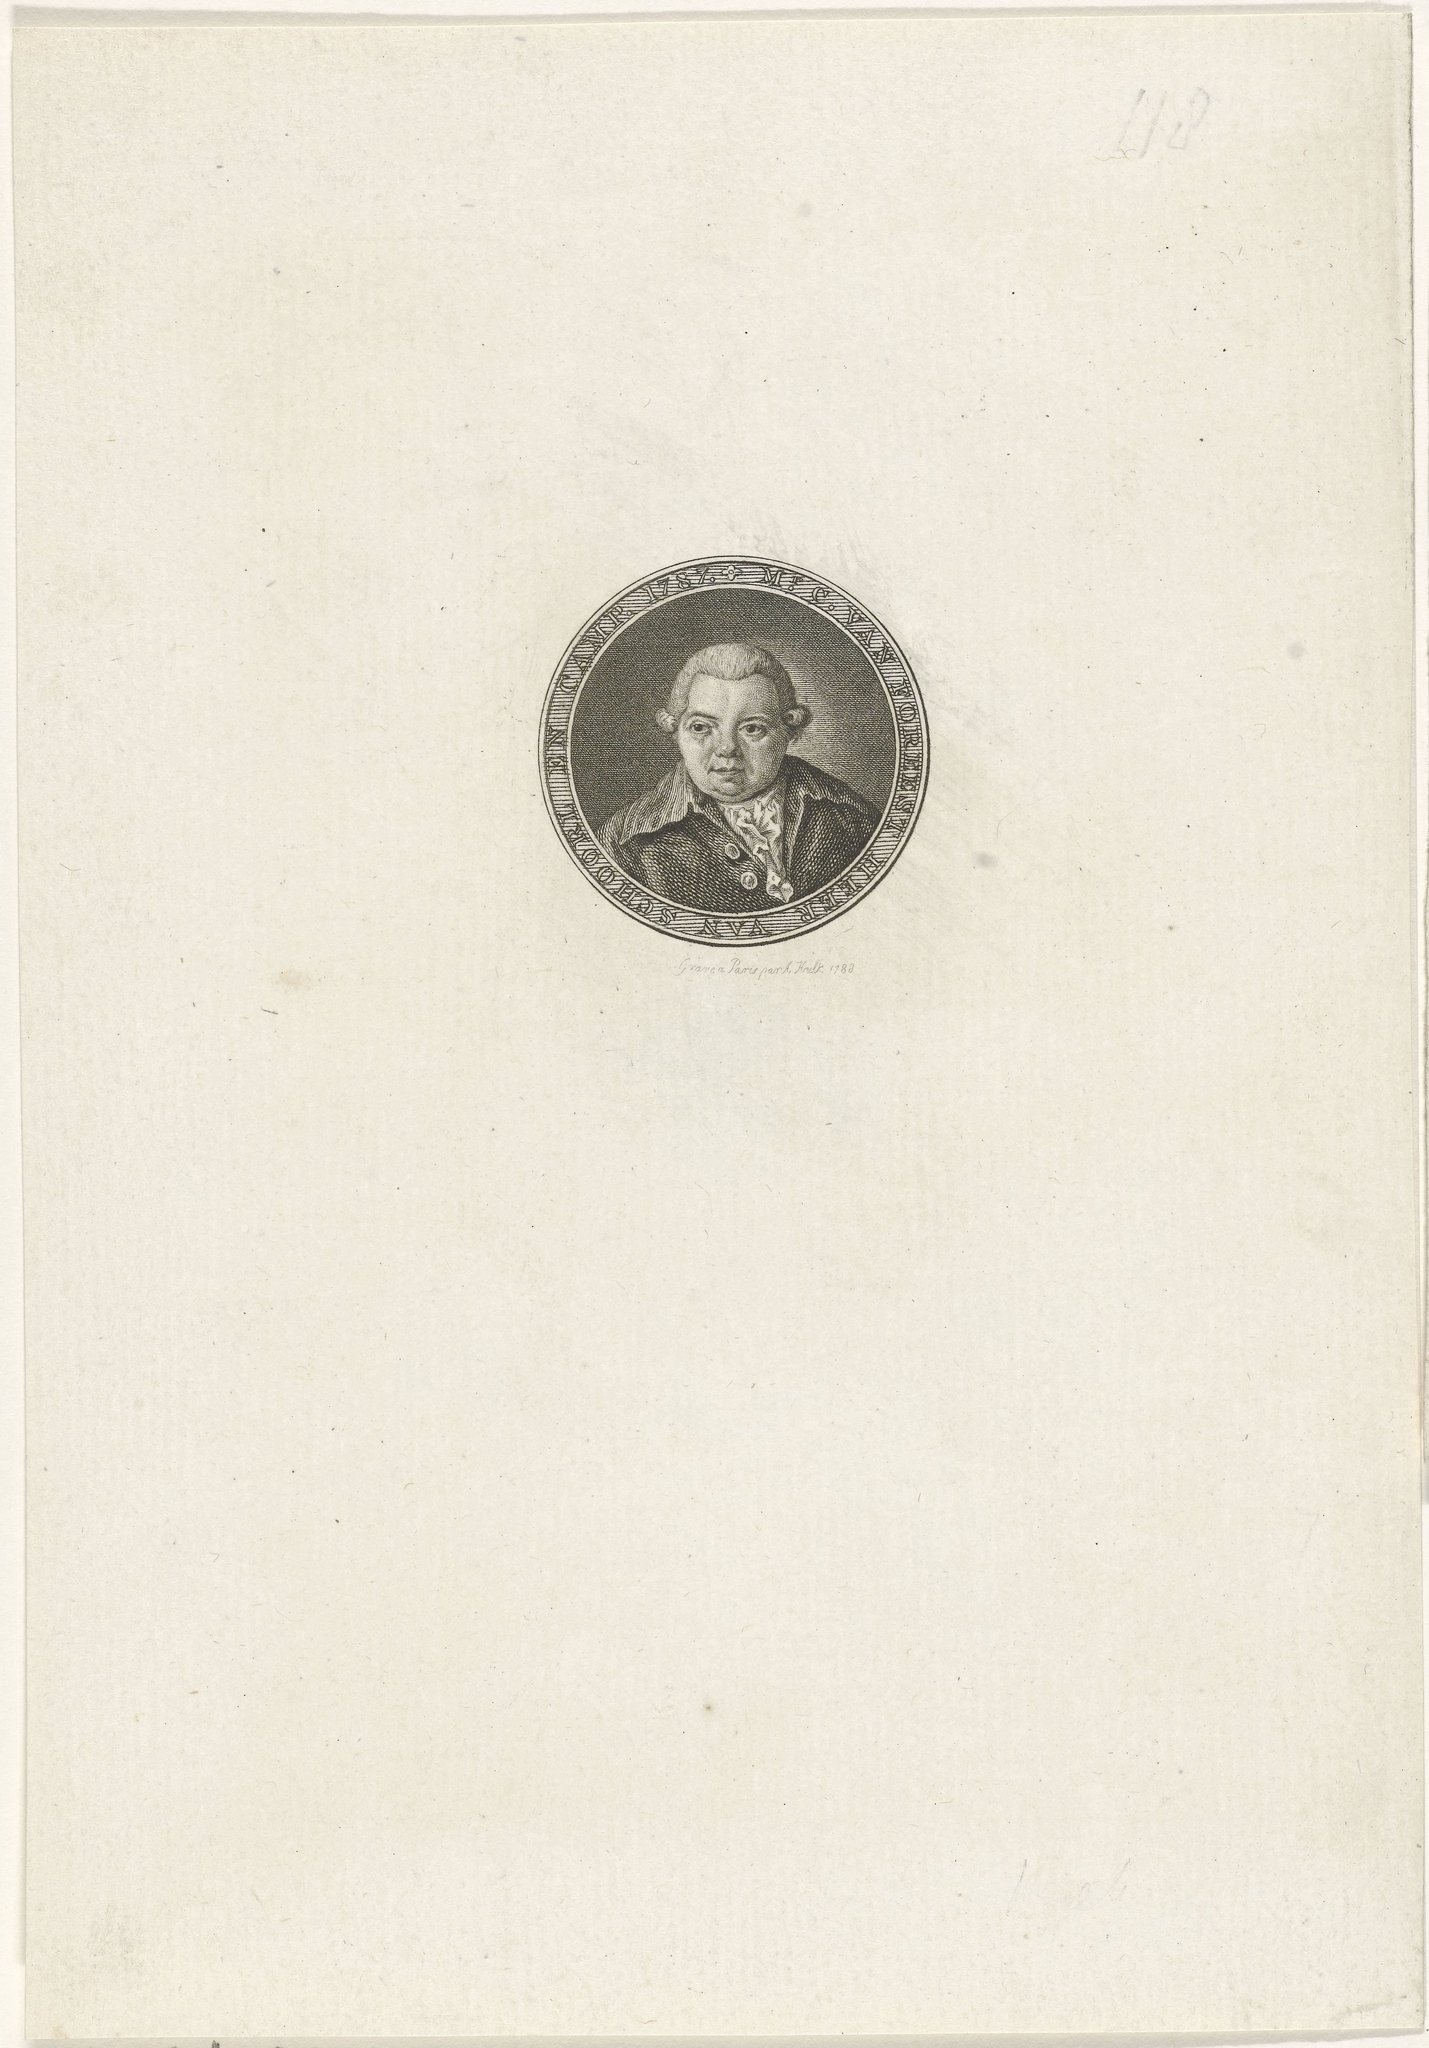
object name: print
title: Portret van Cornelis van Foreest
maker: abraham jacobsz. hulk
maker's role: print maker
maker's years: 1751-1817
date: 1787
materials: paper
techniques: engraving, etching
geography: paris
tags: heiloo, cornelis van foreest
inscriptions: collector's mark: Lugt 2228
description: Buste van Cornelis van Foreest naar rechts in een medaillon met randschrift in het Nederlands.